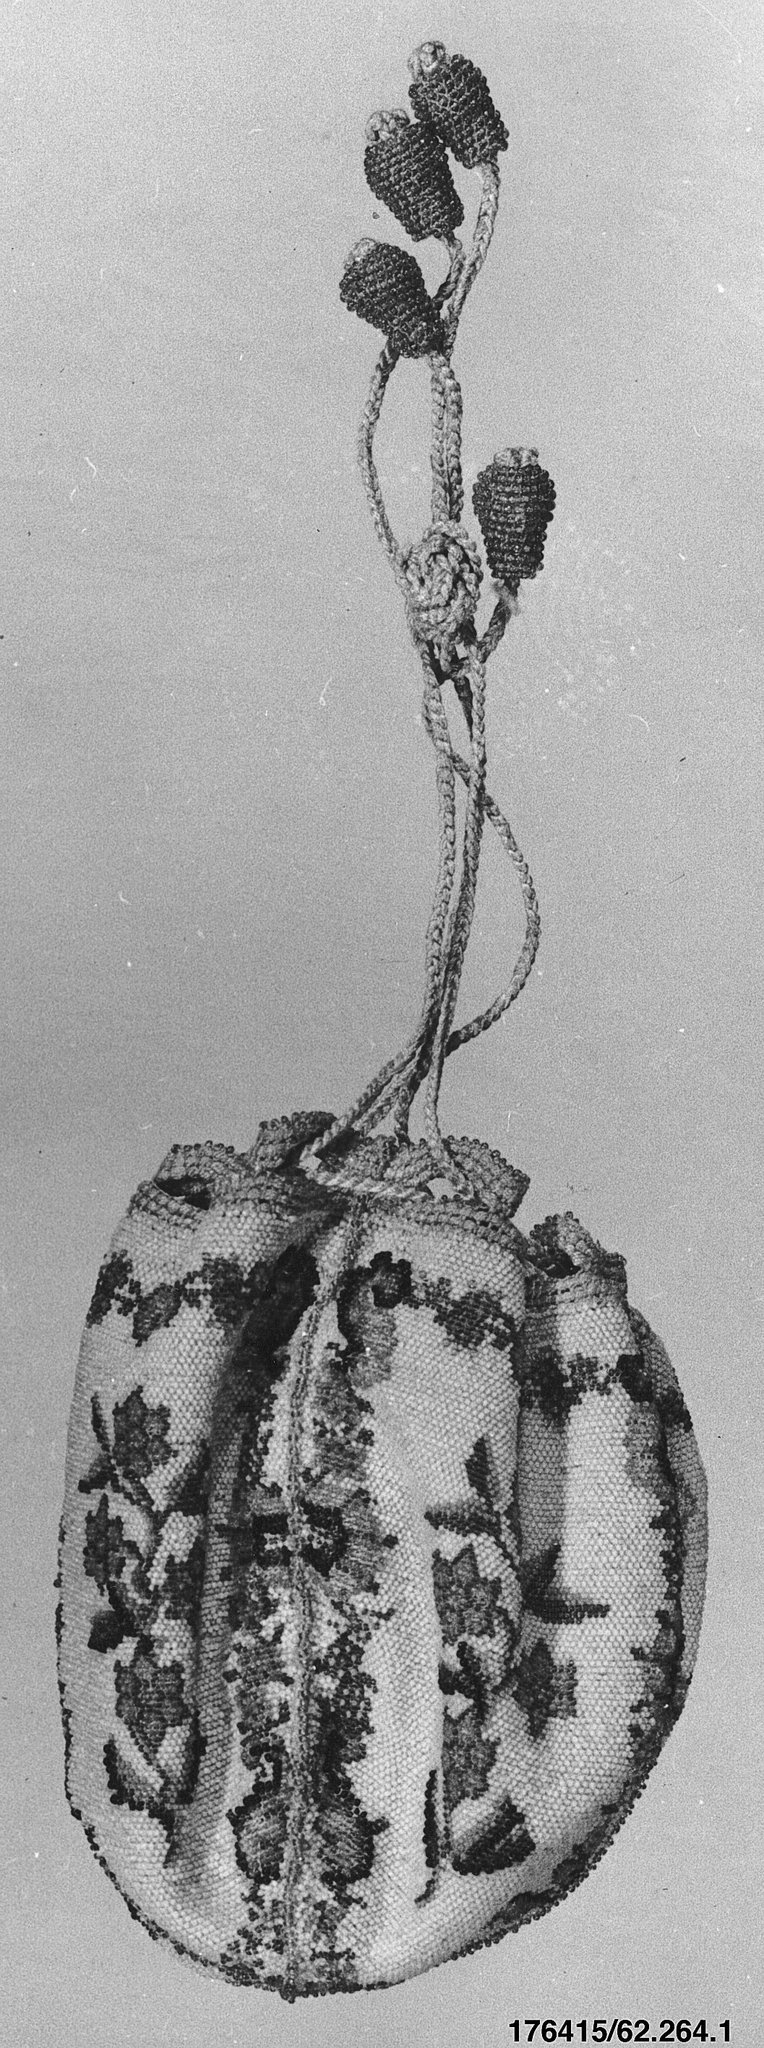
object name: purse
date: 1701-1800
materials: glass, silk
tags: flowers